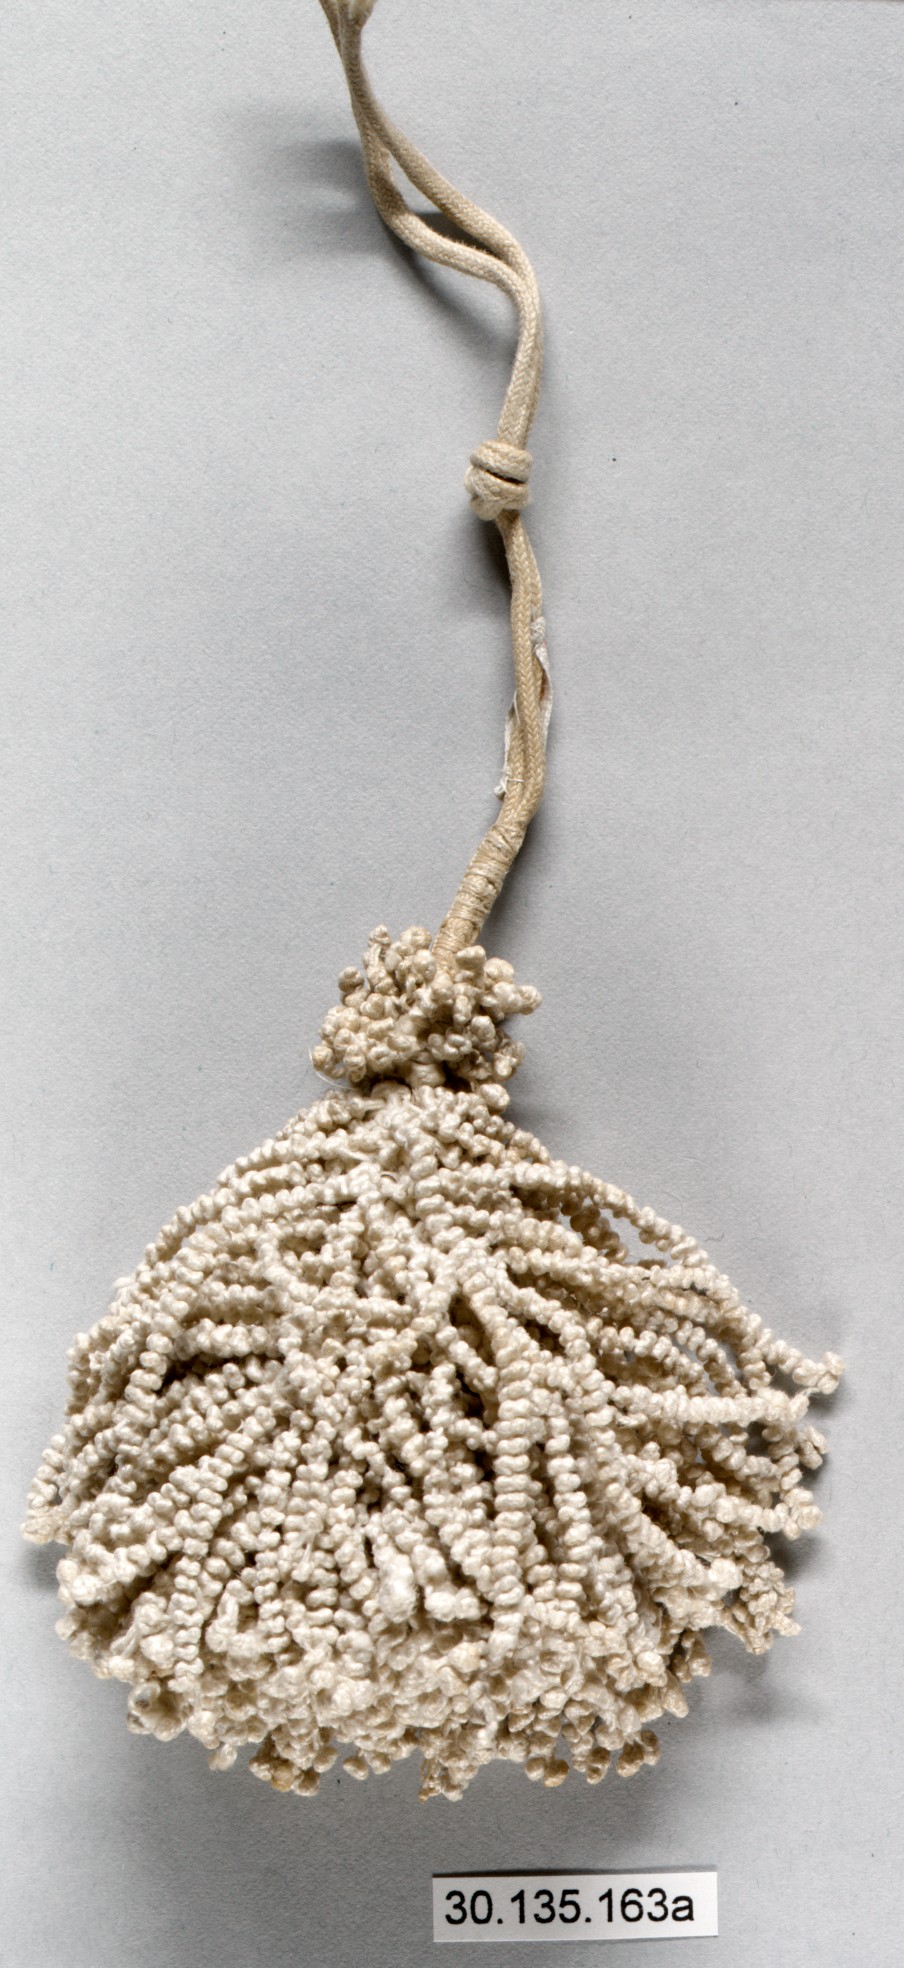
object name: tassel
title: Pair of tassels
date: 1601-1700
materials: linen